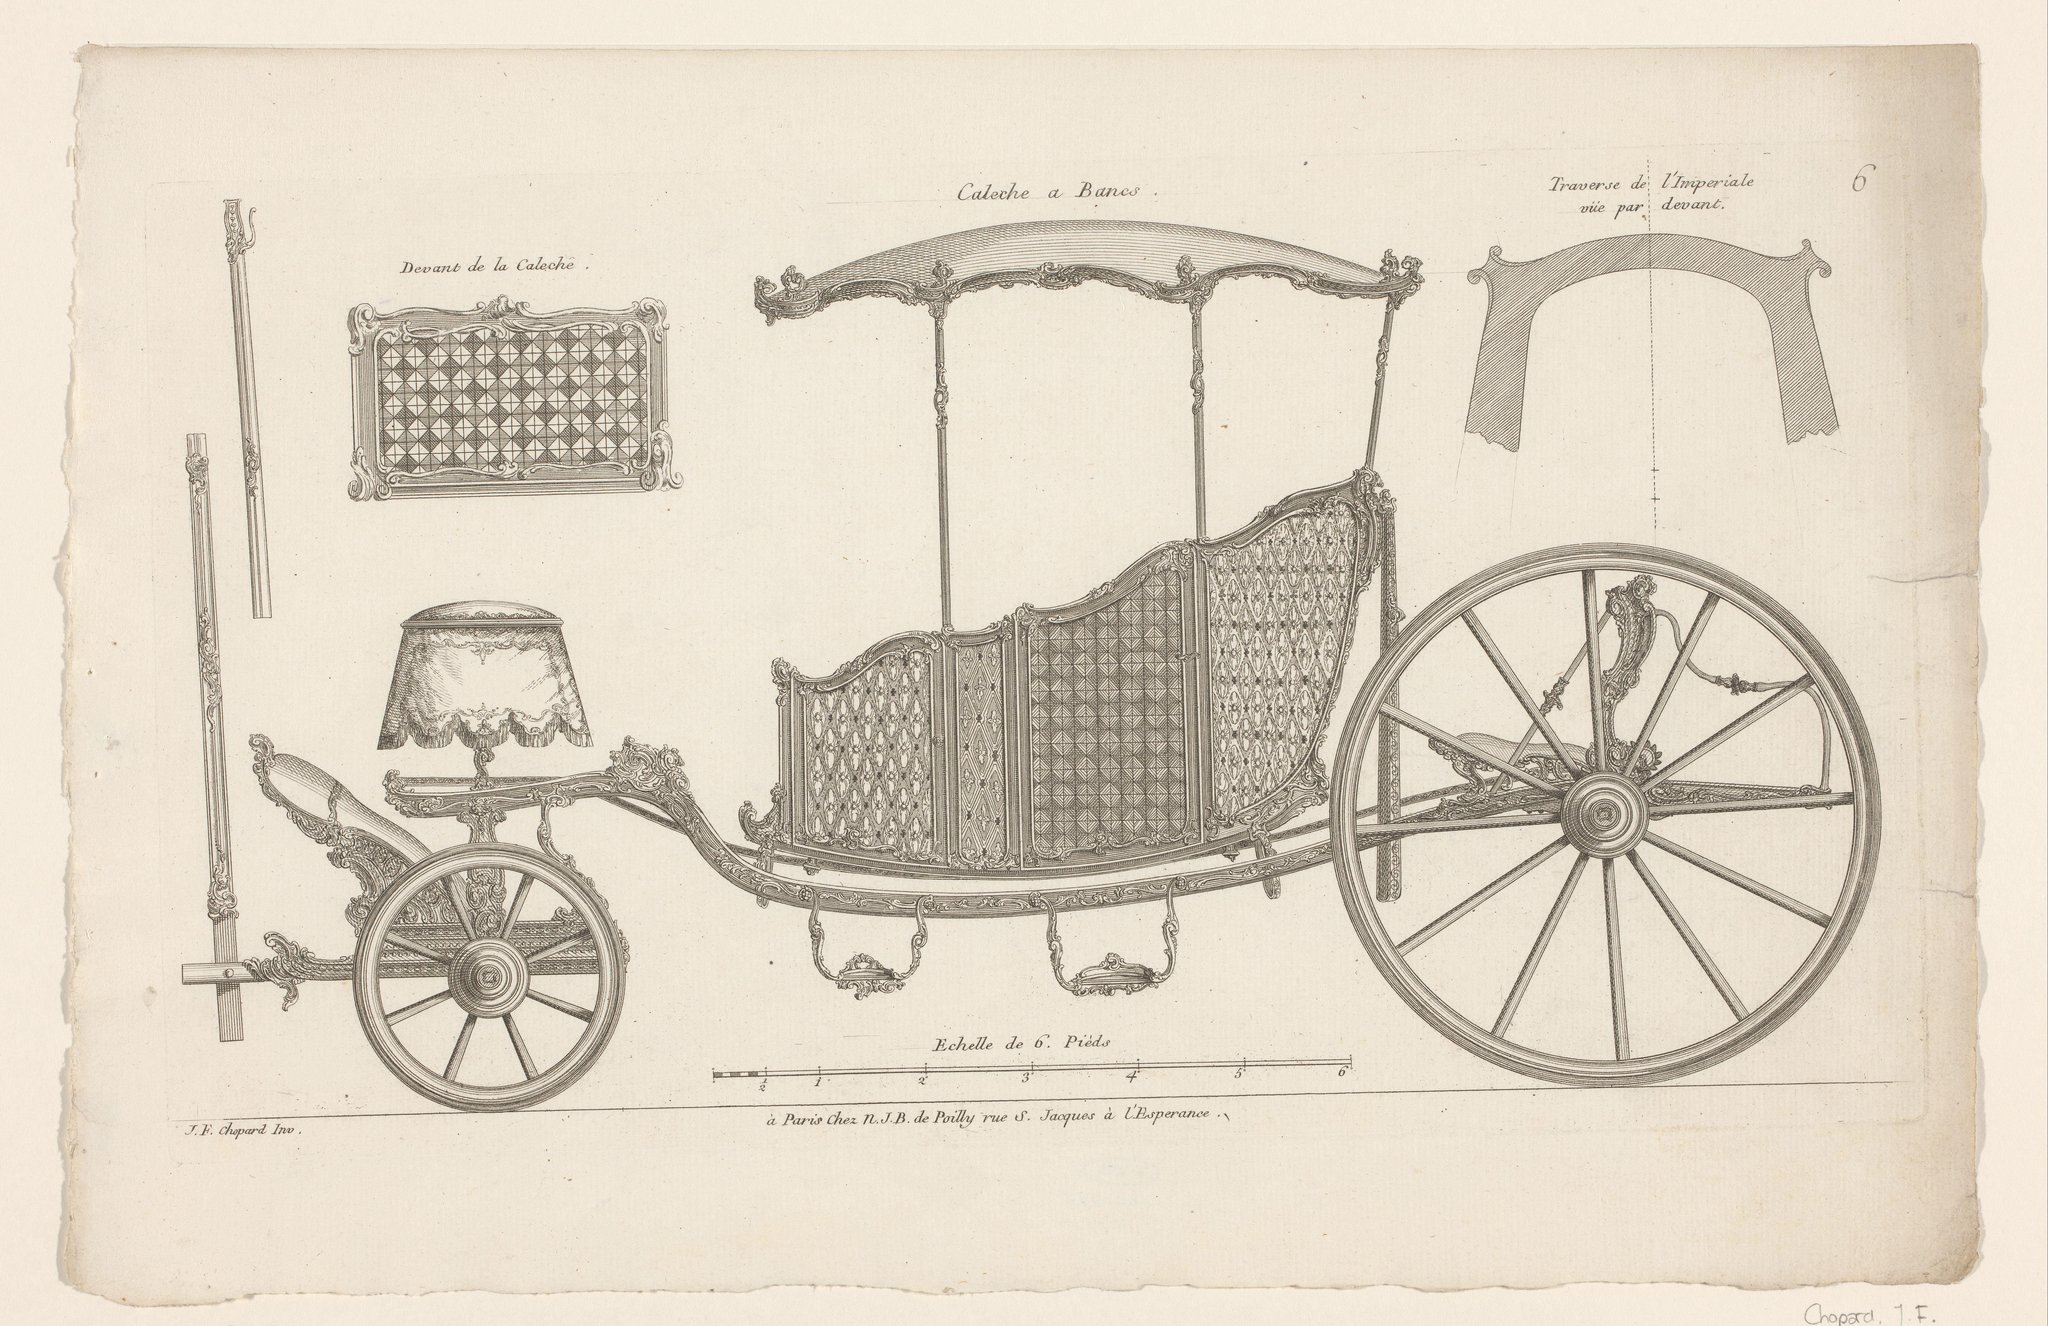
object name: ornament print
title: Modèles de voitures Louis XV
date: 1740-1758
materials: paper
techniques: engraving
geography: paris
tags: four-wheeled, animal-drawn vehicle, e.g.: cab, carriage, coach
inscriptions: collector's mark: Lugt 2228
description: Calèche met afdak. Een calèche is een open rijtuig met halve, inklapbare bank.